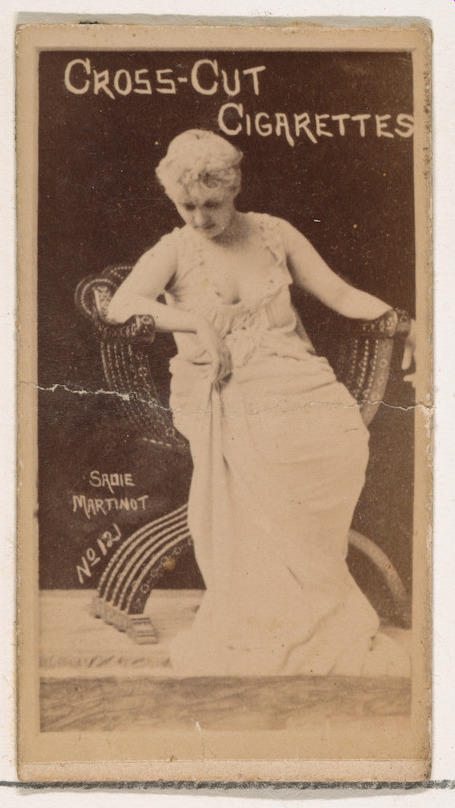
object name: print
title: Card Number 121, Sadie Martinot, from the Actors and Actresses series (N145-1) issued by Duke Sons & Co. to promote Cross Cut Cigarettes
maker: w. duke, sons & co.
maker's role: publisher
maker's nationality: american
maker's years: 1870-1920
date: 1880-1889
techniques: albumen silver print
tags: portraits,women,actresses